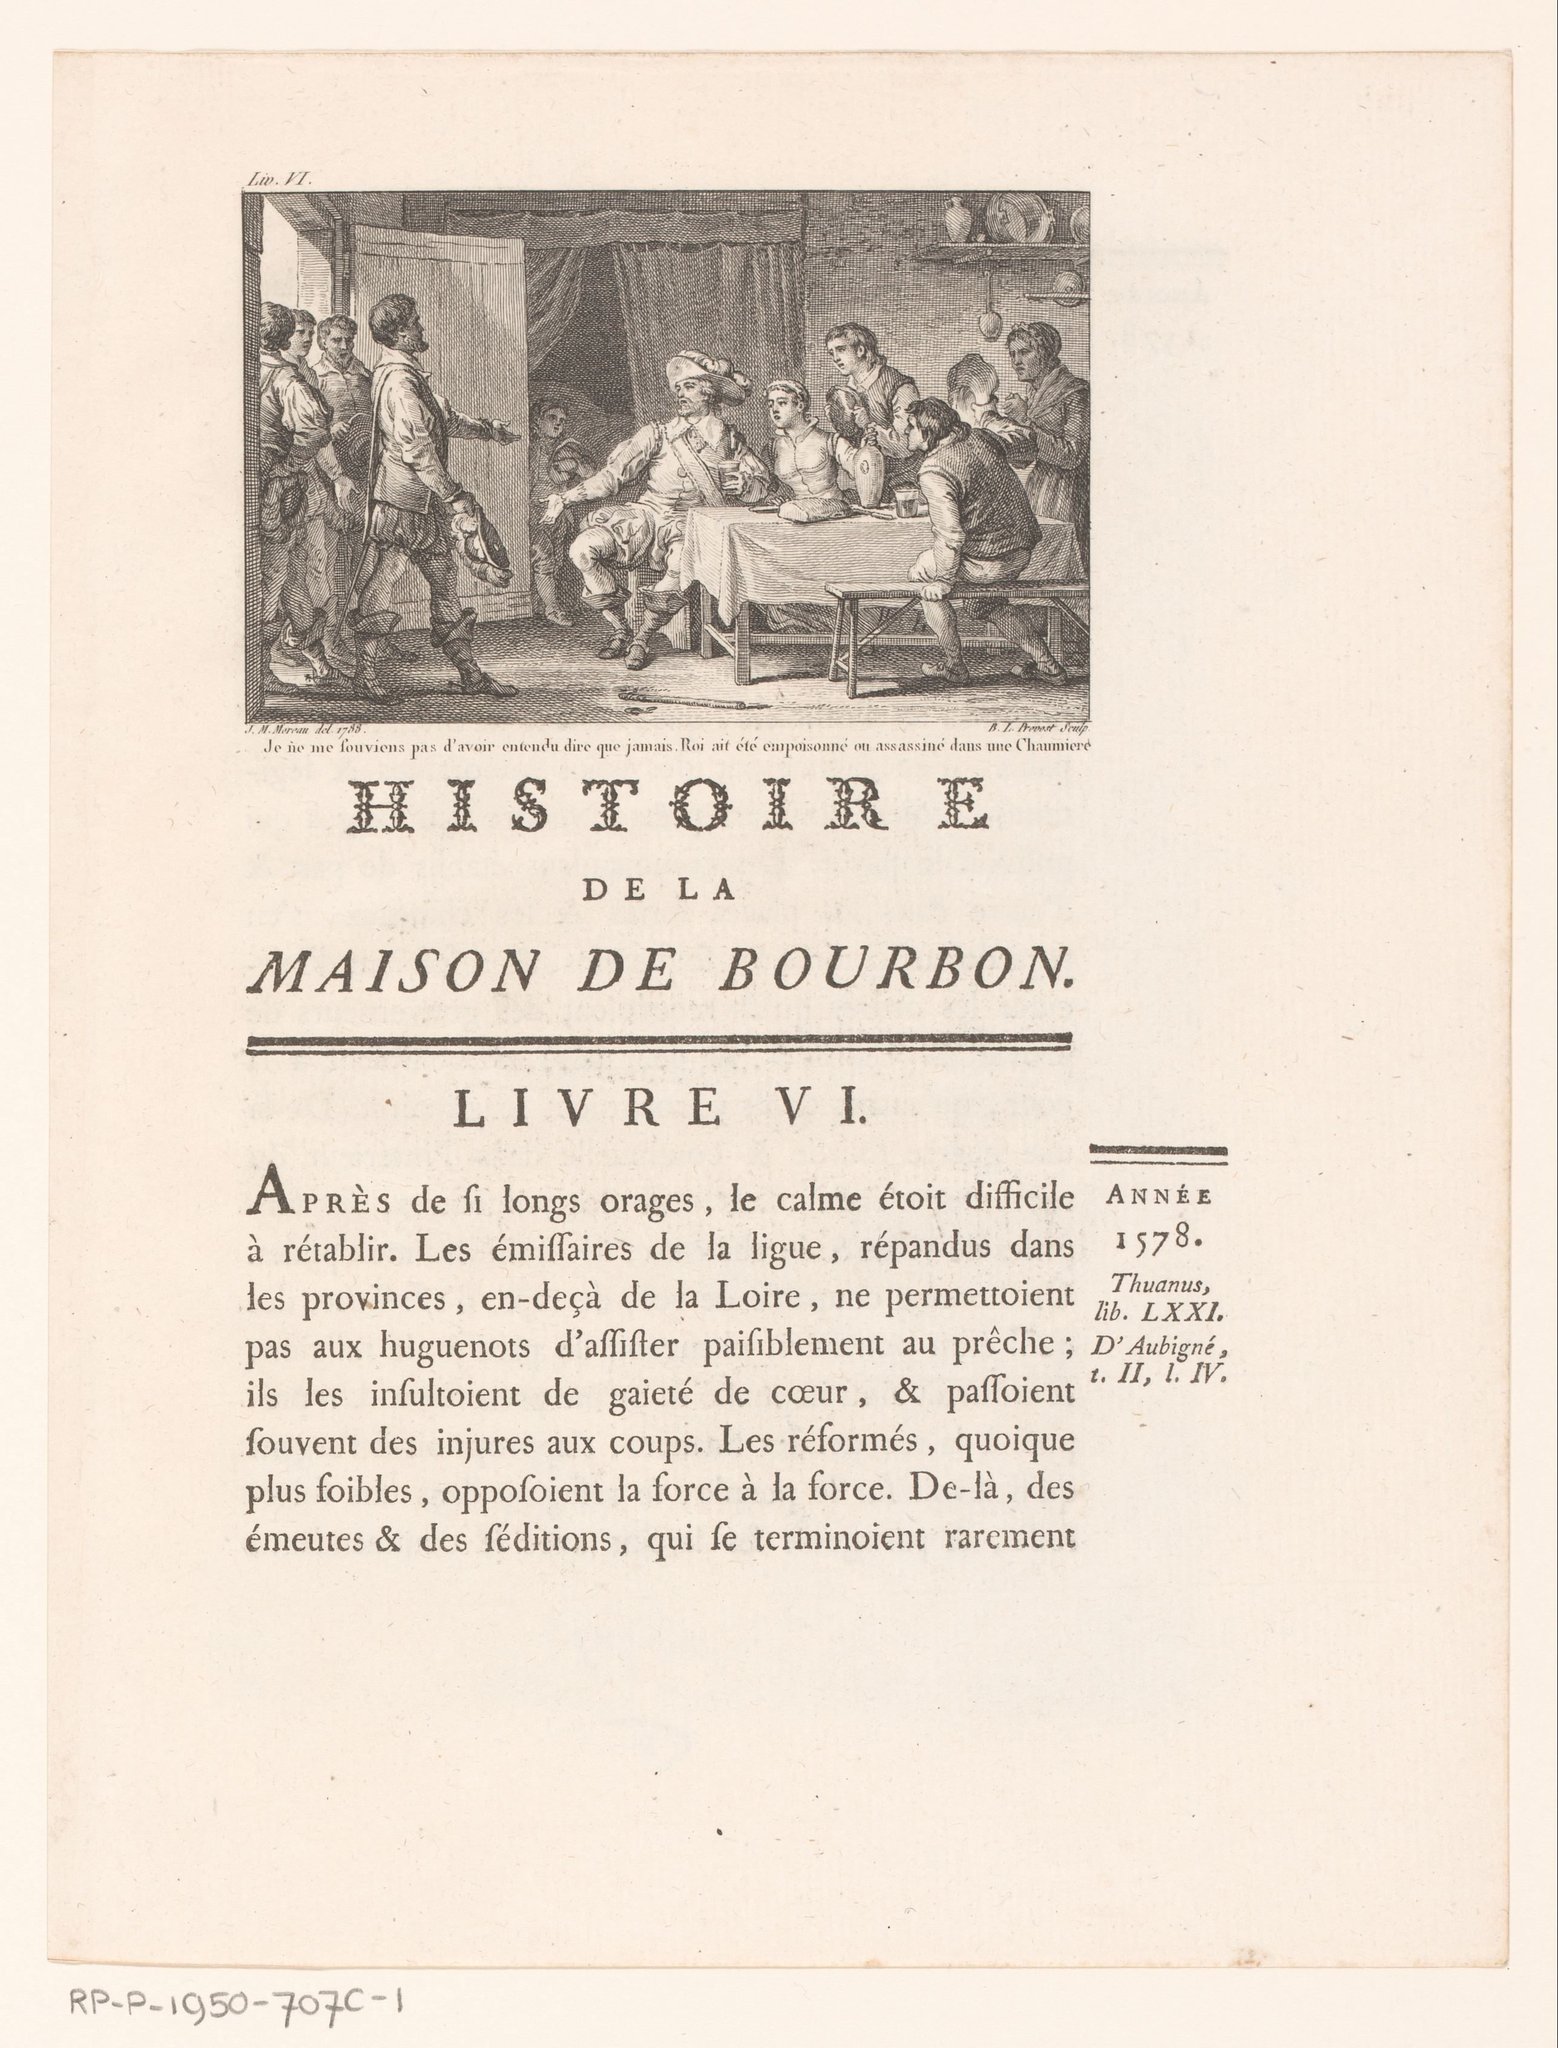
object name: print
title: Herberginterieur met mannen in gesprek over de dood van Hendrik IV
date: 1788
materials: paper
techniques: engraving, etching, letterpress printing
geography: paris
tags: inn, coffee-house, public house, etc., king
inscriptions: collector's mark: Lugt 2228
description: Prent uit: Désormeaux, Joseph-Louis-Ripault. Histoire de la maison de Bourbon. Parijs: L'Imprimerie Royale, 1788, dl. 5, p. 157.